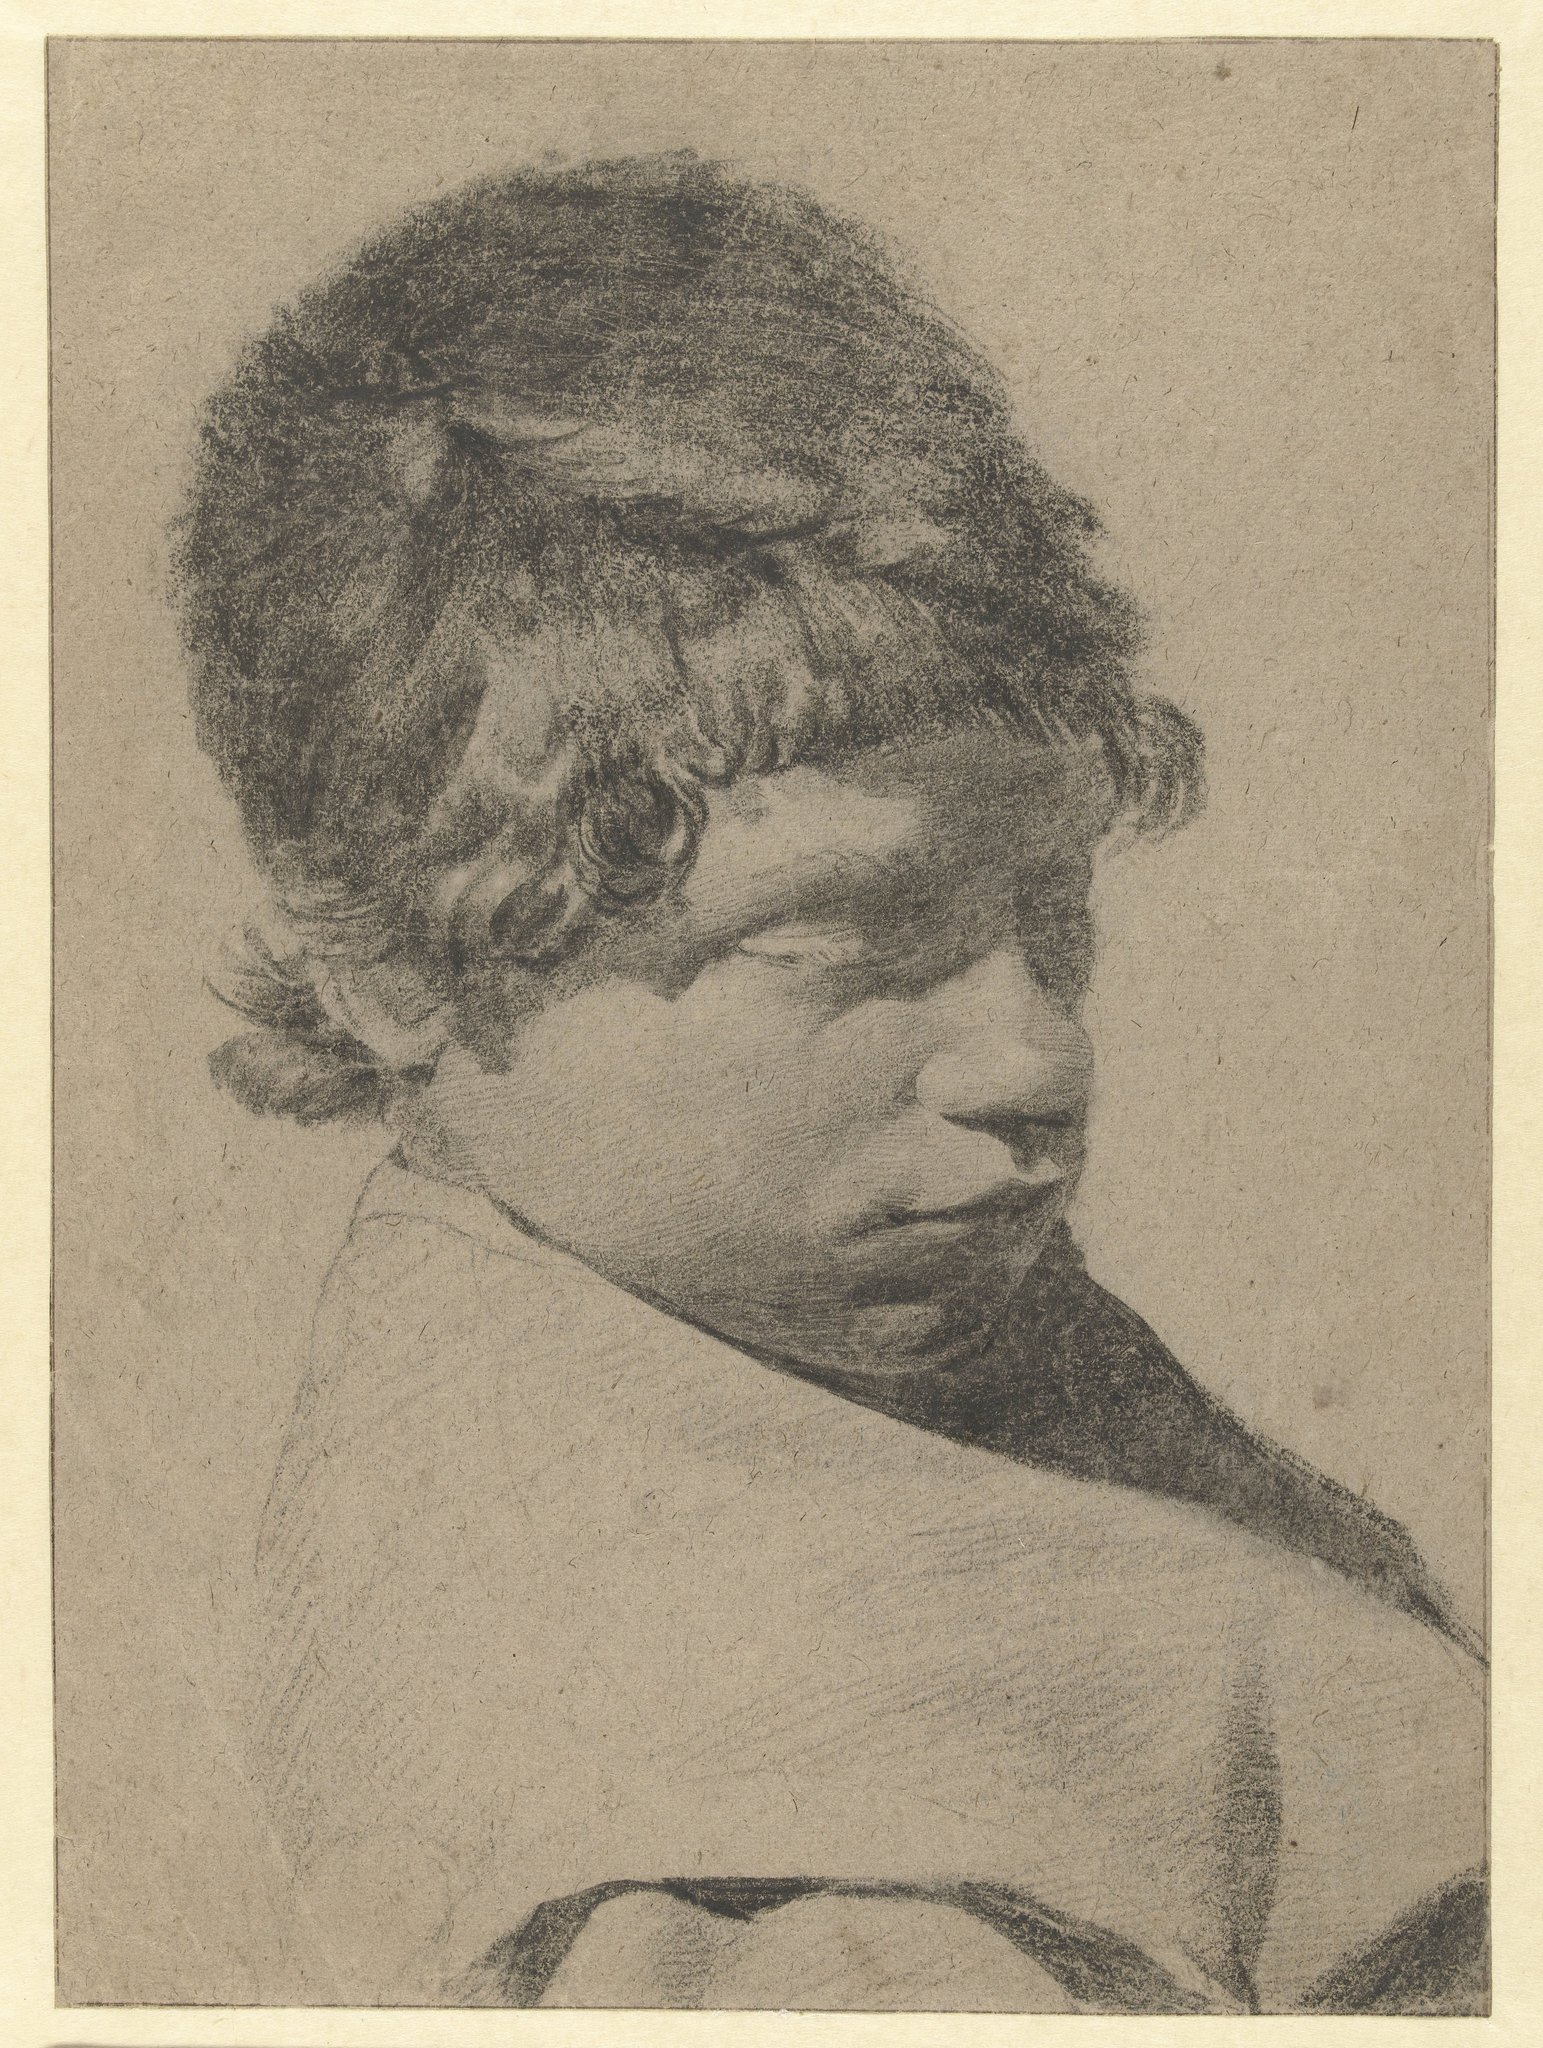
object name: drawing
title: Buste van een jongen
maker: leendert van der cooghen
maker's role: draughtsman, print maker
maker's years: 1632-1681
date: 1642-1681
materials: chalk, paper